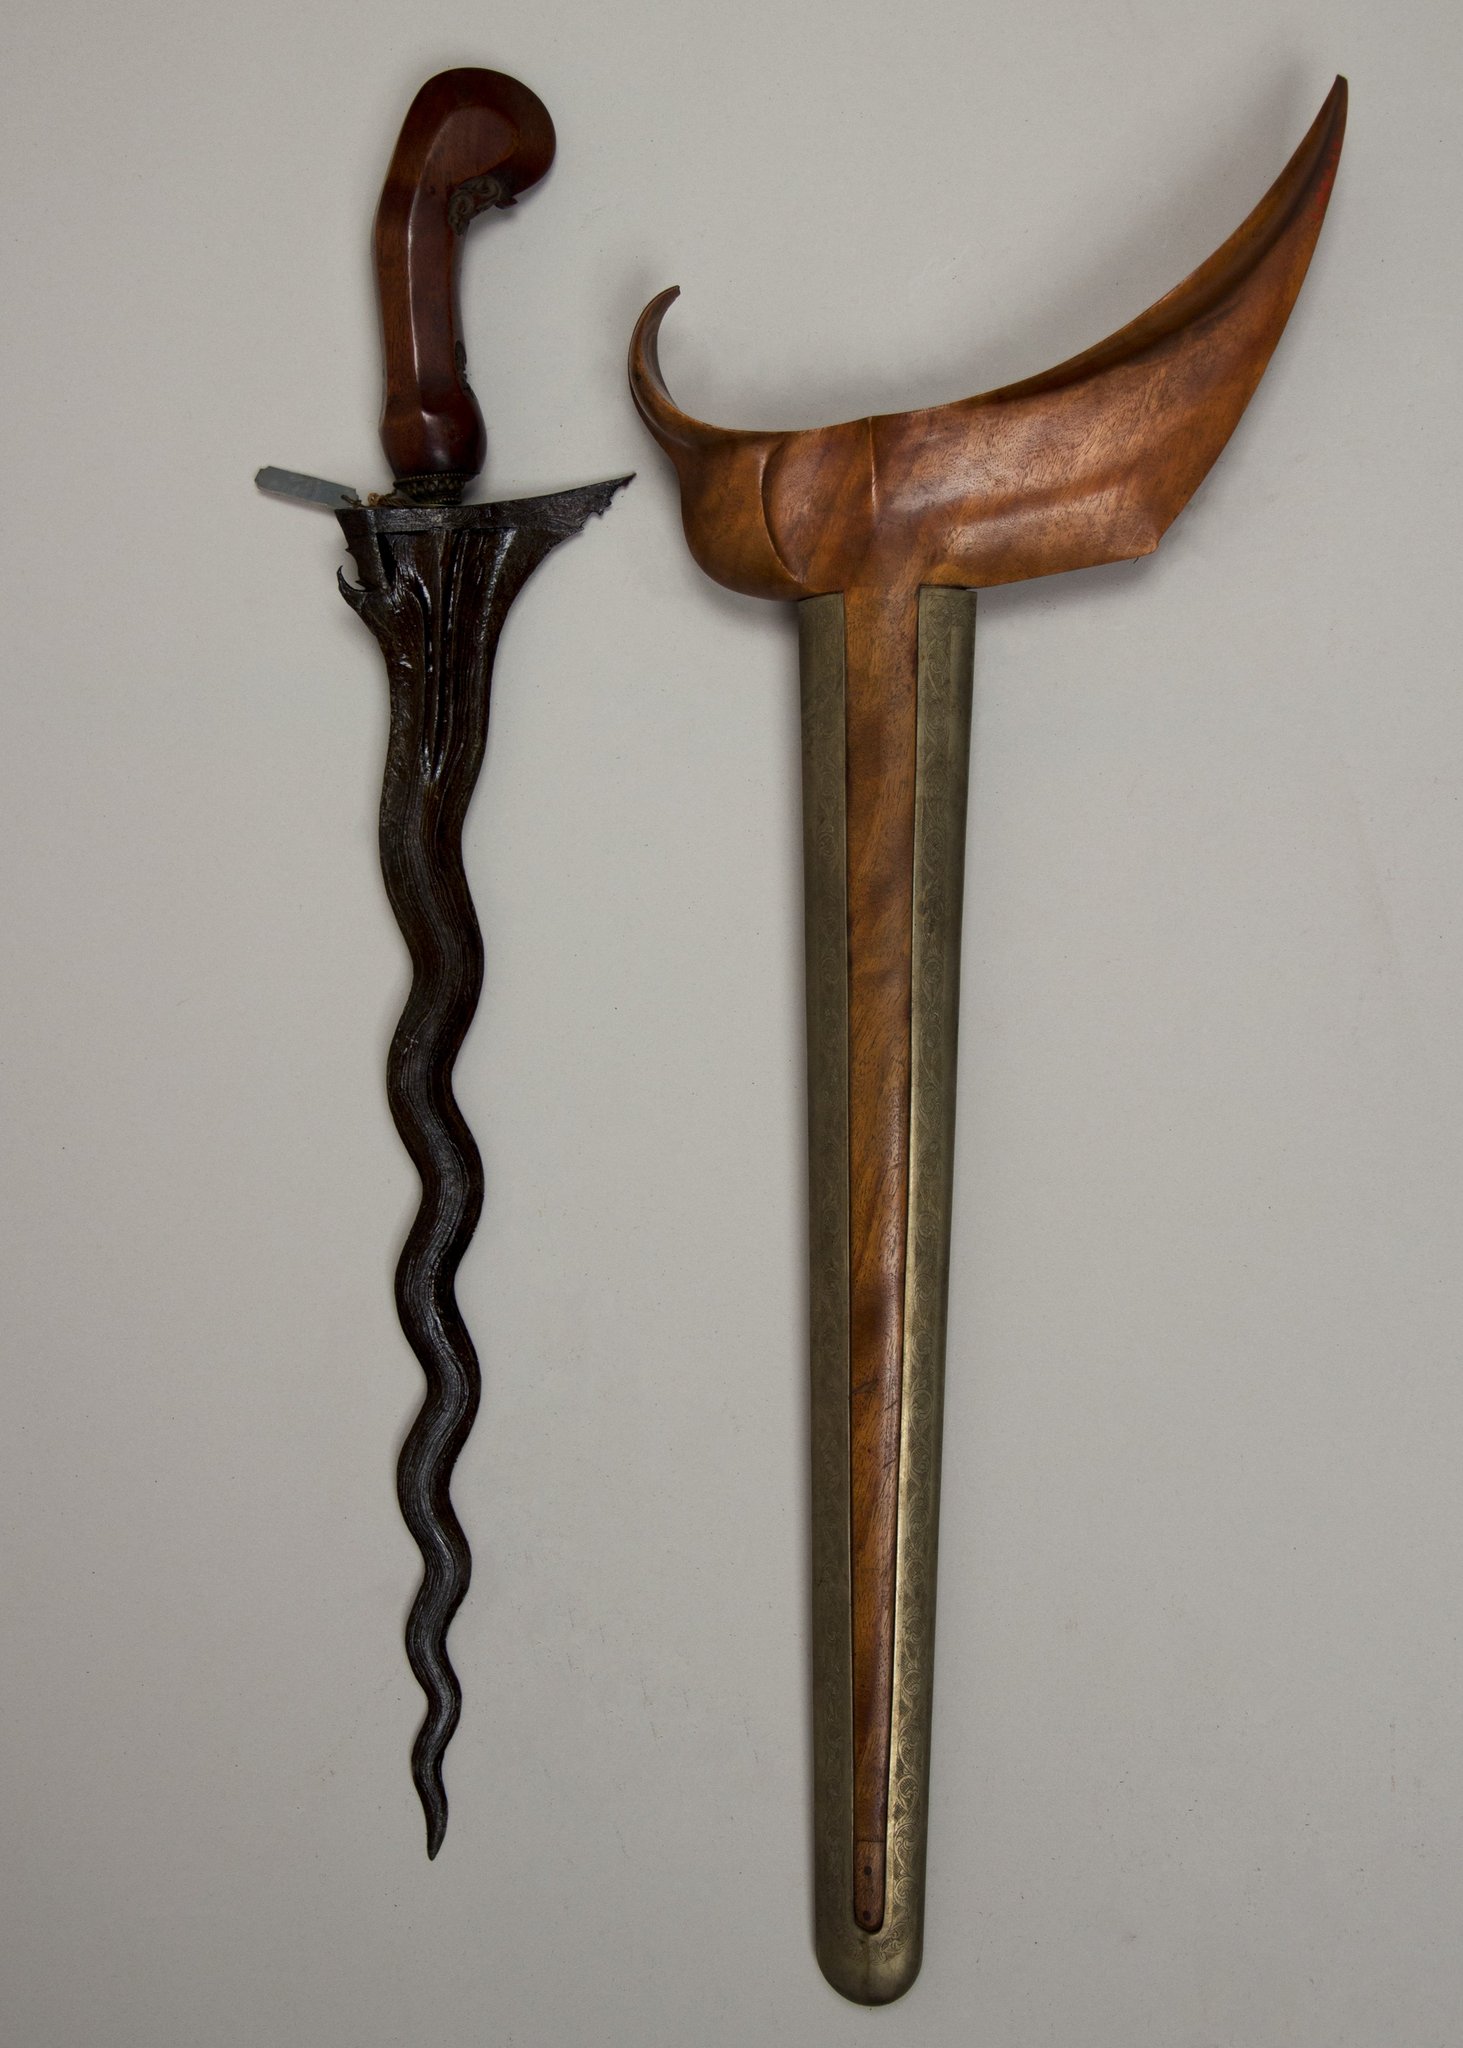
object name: kris with sheath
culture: javanese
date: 1501-1900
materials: wood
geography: indonesia